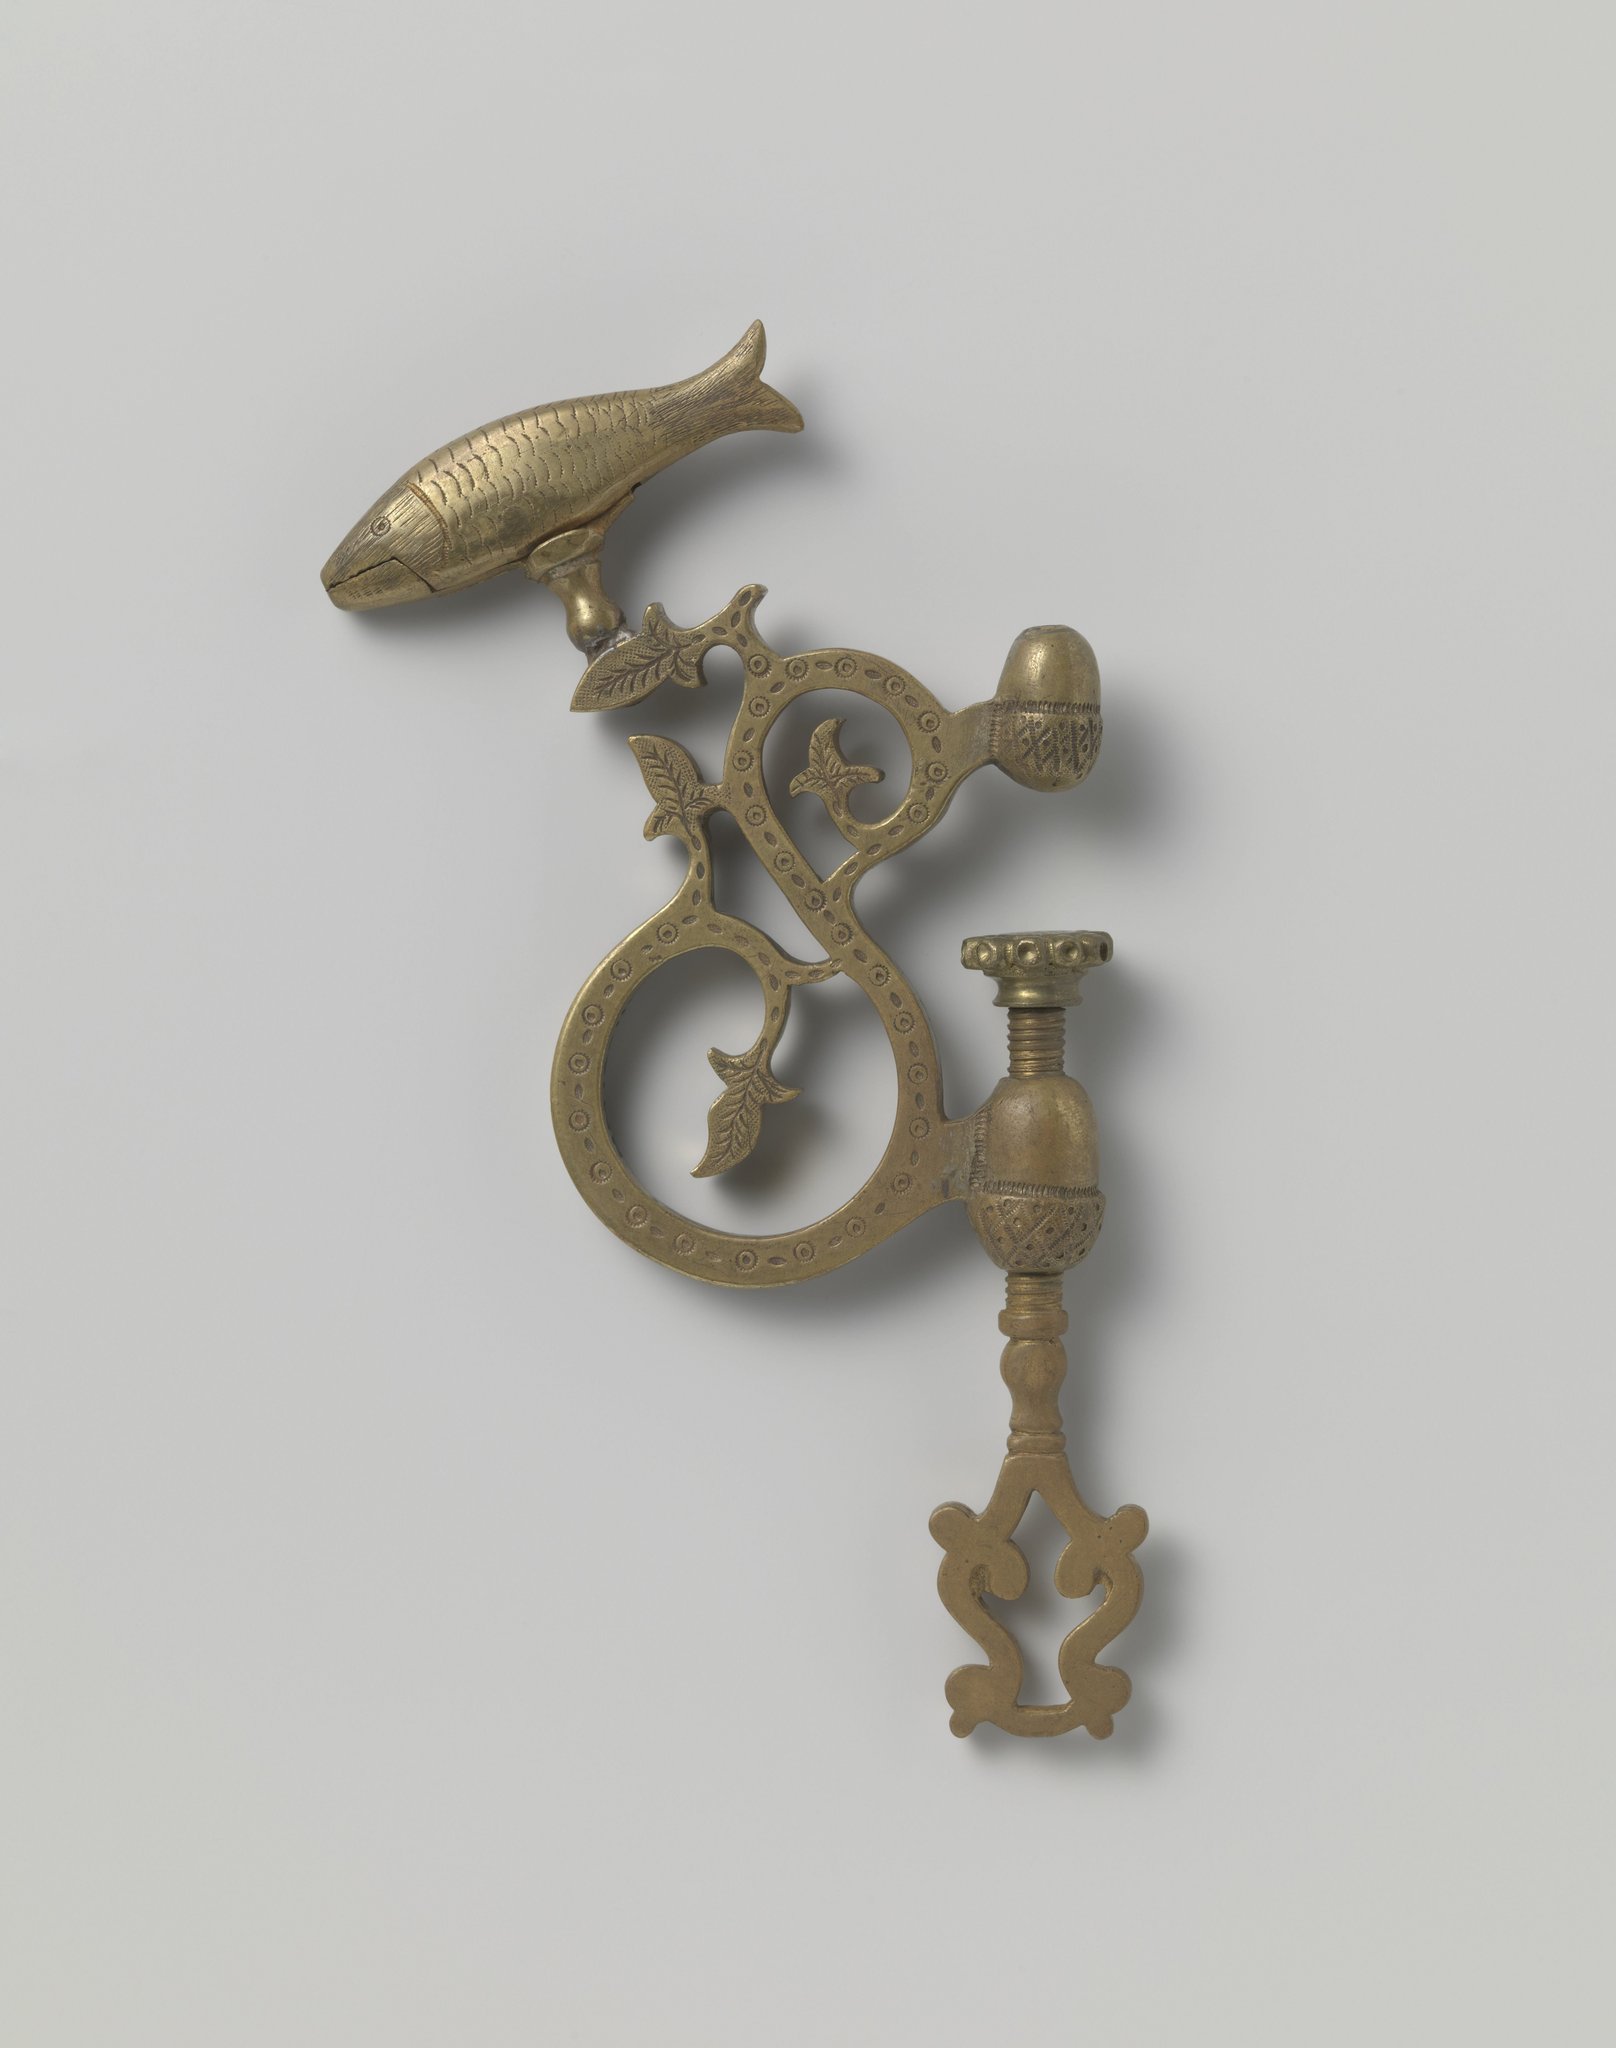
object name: naaischroef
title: Naaischroef, gedecoreerd met een eikel en een vis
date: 1700-1800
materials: brass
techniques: casting, metalworking, engraving, punching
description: Het voorwerp is gegoten en geciseleerd en vervolgens gedeeltelijk geponst bewerkt en gegraveerd. Het bestaat uit vier delen: de schroef met het handvat en de knop, de tafelklem, het balustertje, de vis. Het handvat en de knop van de schroef zijn versierd. De tafelklem bestaat uit twee eikels, die met een S-vorm en vier bladeren met elkaar in verbinding staan. Op het bovenste blad is het balustertje gesoldeerd, dat één geheel vormt met het bekdeel van de vis. In dit dier is een veer aangebracht zodat de bek dicht valt. In de bovenste eikel van de tafelklem is een gat, met aan de binnenkant een schroefdraad.